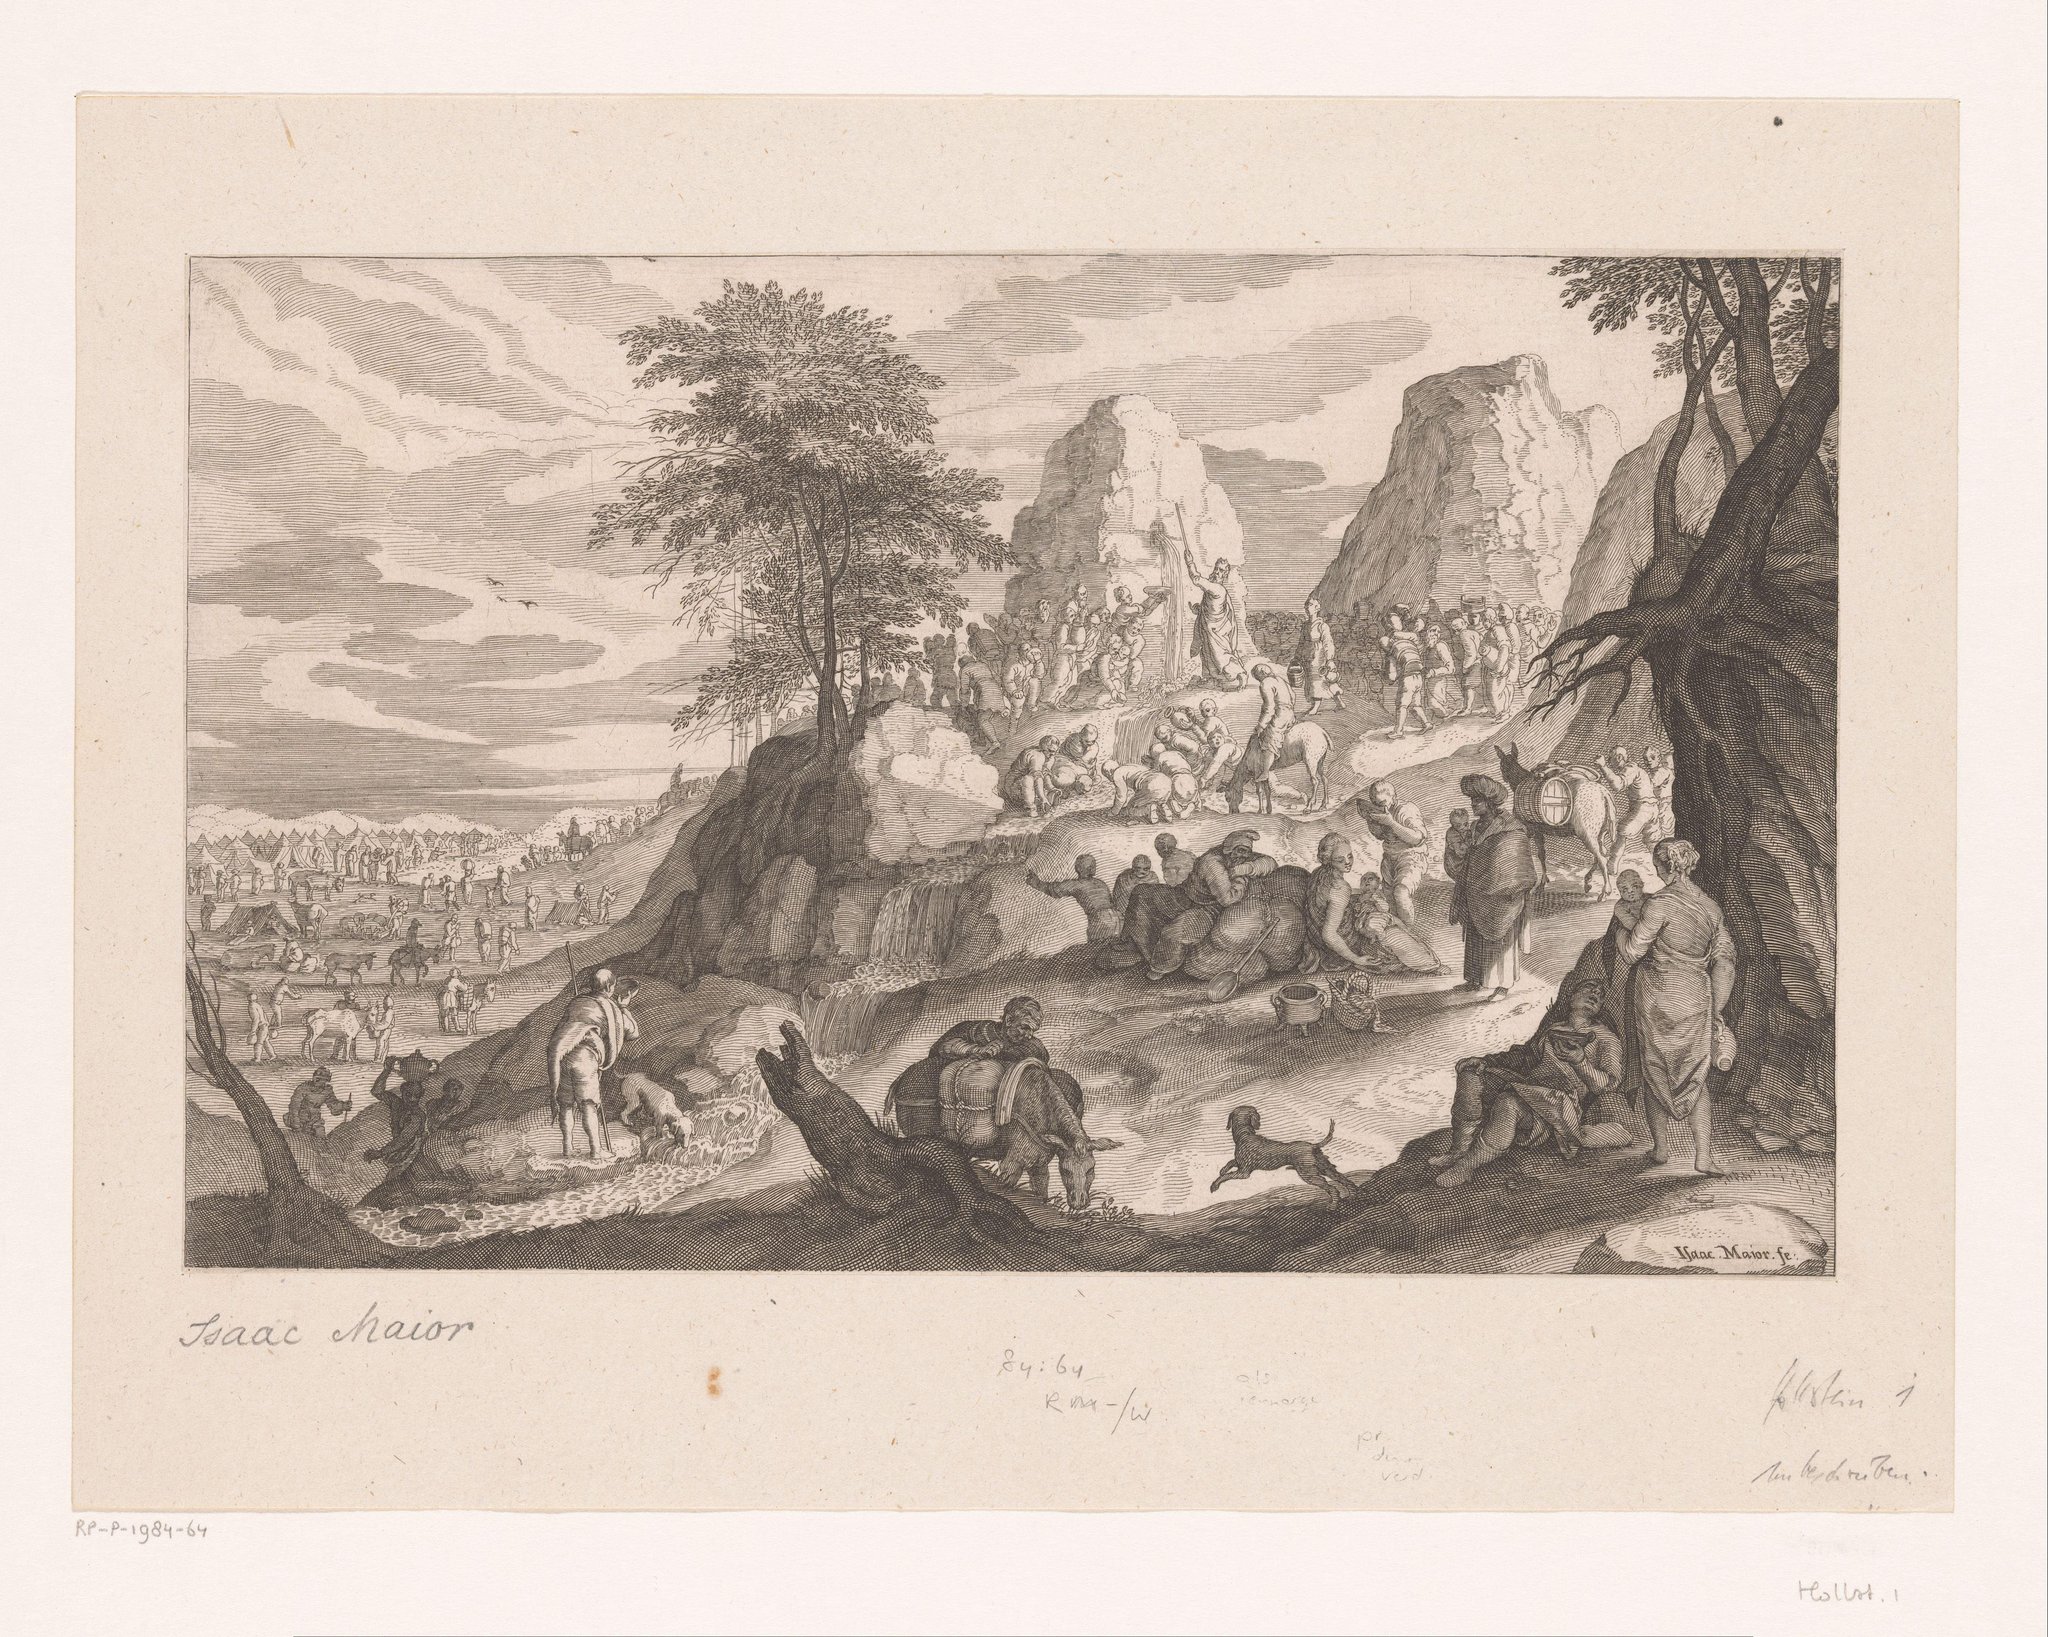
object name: print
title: Landschap met Mozes die water uit de rots slaat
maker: isaak major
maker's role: print maker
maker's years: 1576-1642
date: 1586-1630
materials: paper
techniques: engraving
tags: moses striking water from the rock (exodus 17:1-7; numbers 20:2-13)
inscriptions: collector's mark: Lugt 2760, collector's mark: Lugt 2228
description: Mozes slaat water uit een rots zodat de Israëlieten, die om hem heen staan met kommen en kruiken, kunnen drinken.